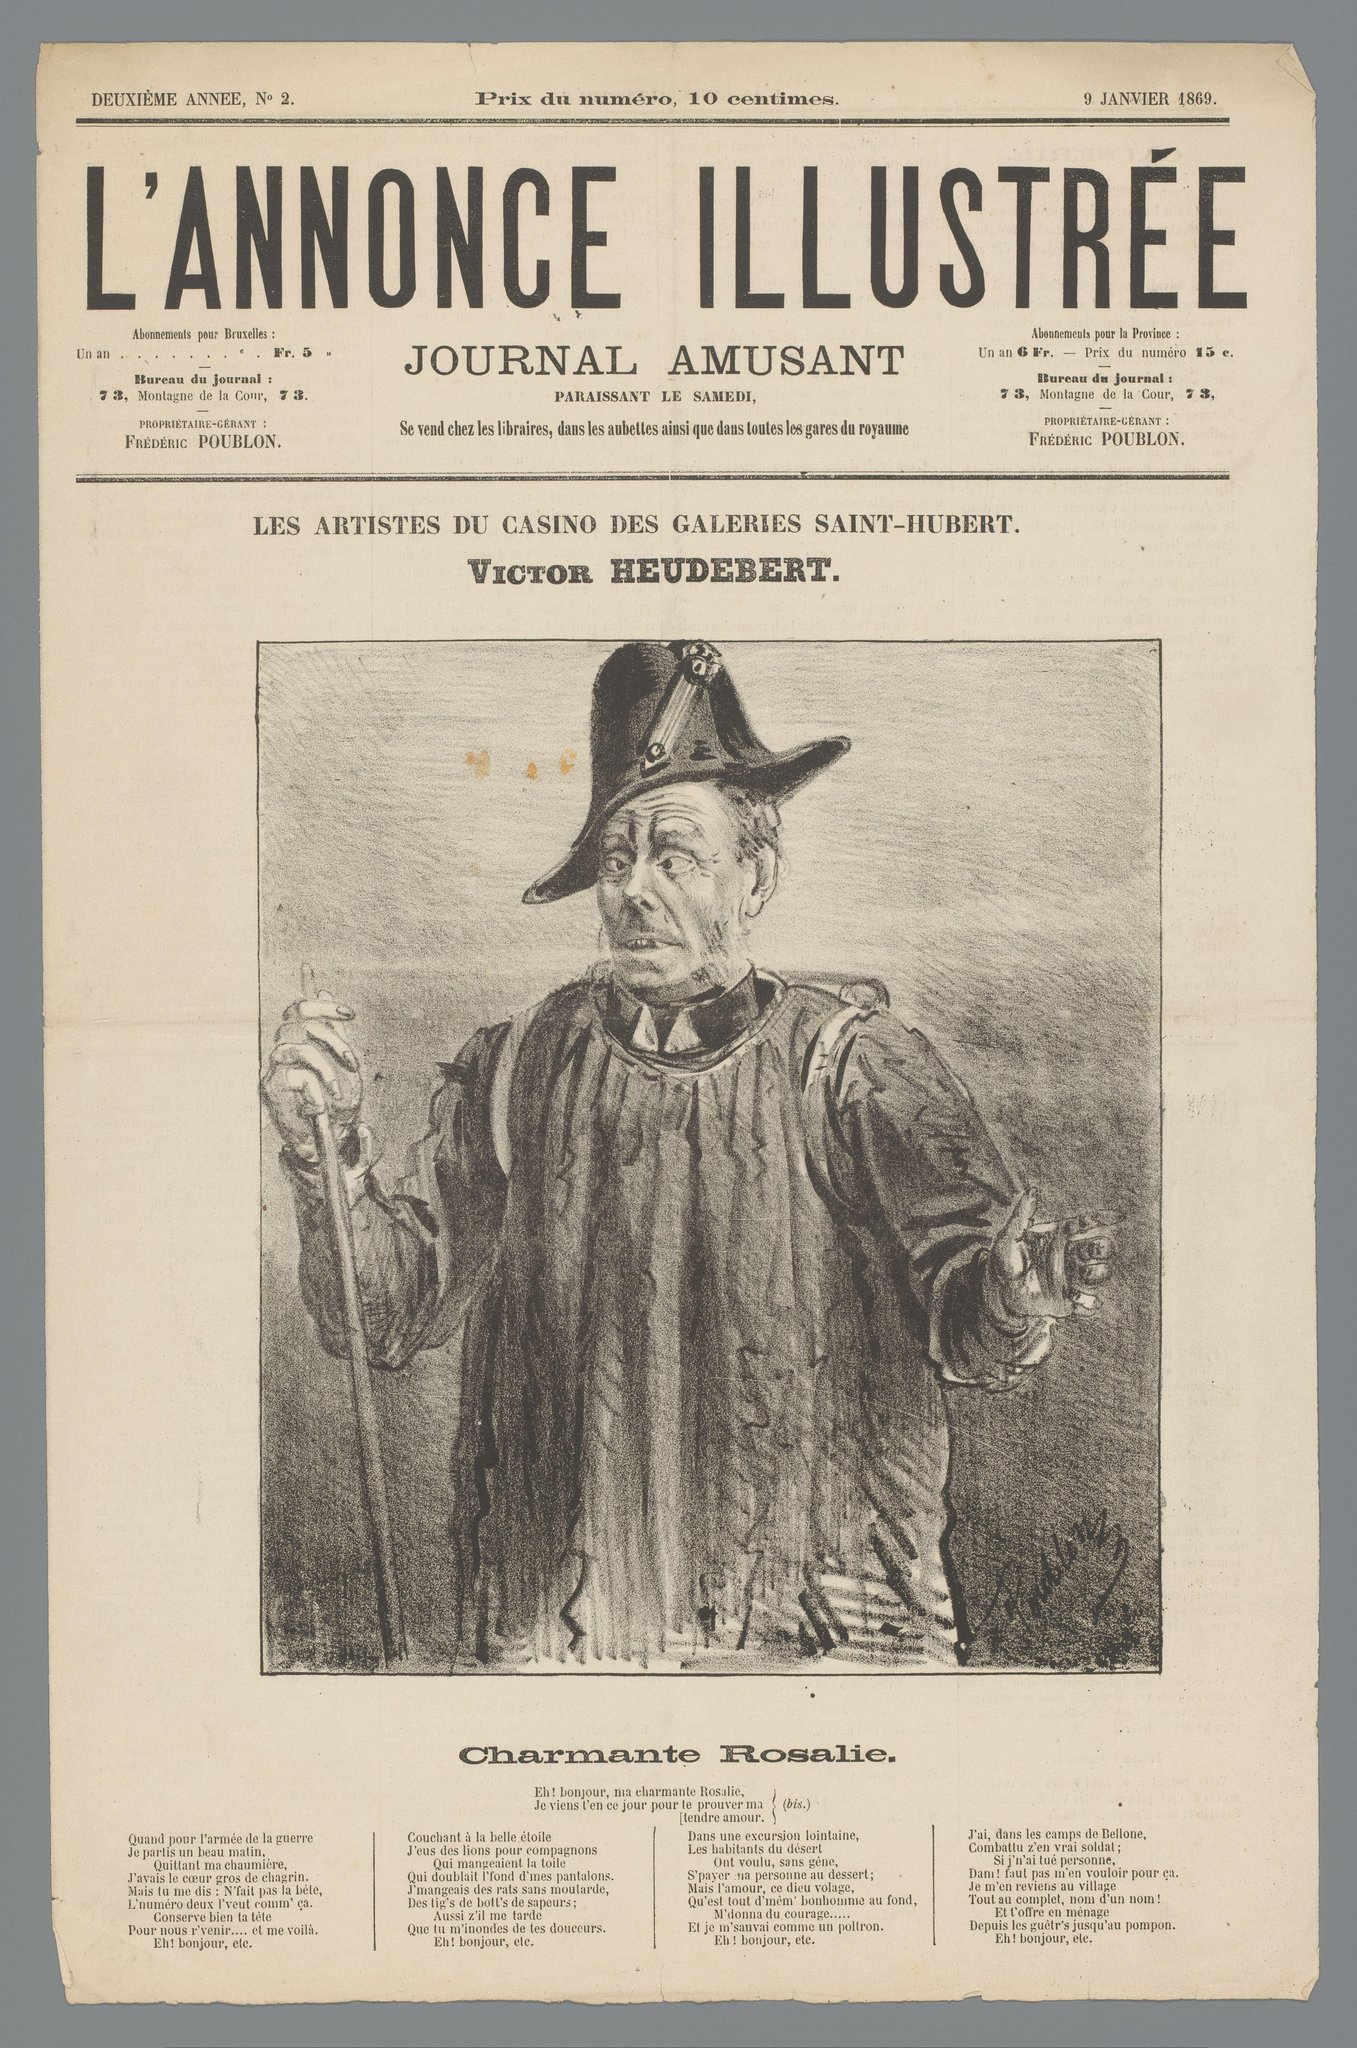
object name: print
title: Victor Heudebert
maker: frédéric poublon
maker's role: print maker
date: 1869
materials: paper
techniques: letterpress printing, lithograph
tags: portrait of actor, actress, actor (on the stage), comedy, brussels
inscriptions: collector's mark: Lugt 2228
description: Prent op voorpagina van: L'Annonce Illustrée, Journal Amusant, 9 januari 1869.